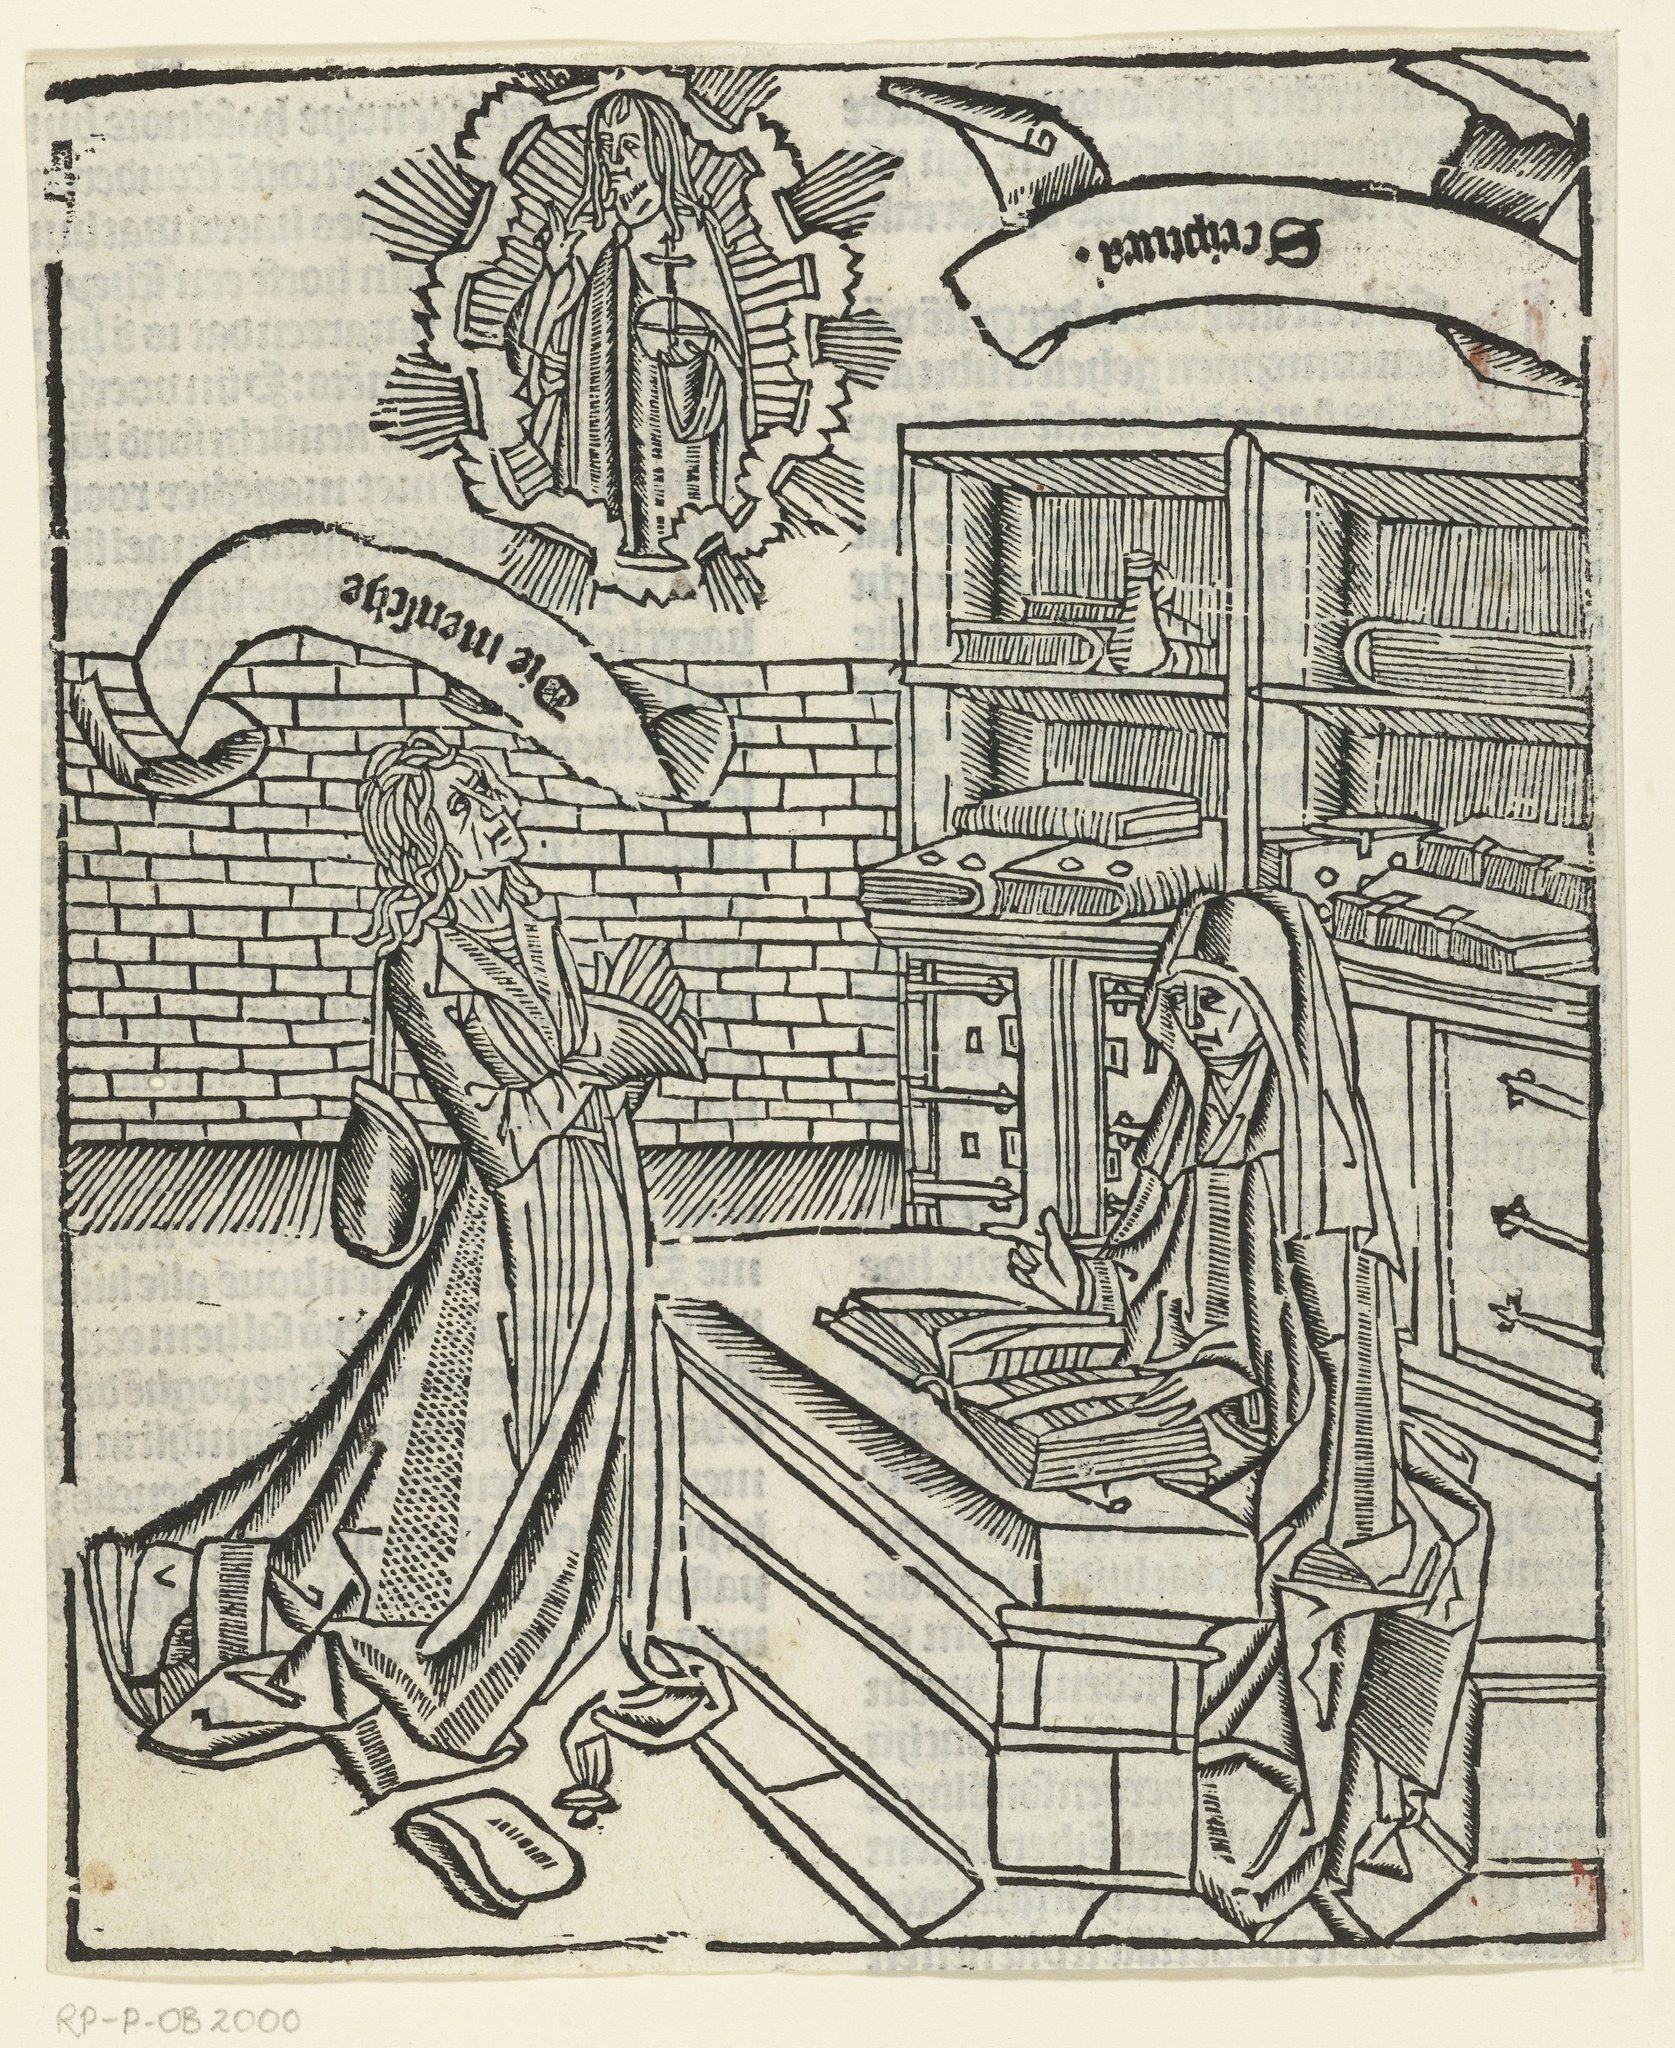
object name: print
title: Die mensche. Scriptura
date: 1480-1500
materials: paper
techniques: woodcut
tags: abstract ideas and concepts (+ abstract concept represented by female figure), reading the bible or other religious books, the bible as a book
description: Eén blad van 113 uit Ludolphus de Saxonia, "Dit es dleué ons liefs heeren ihesu christi". Anonieme Nederlandse vertaling. Uitgegeven door Henrick Eckert van Homberch te Antwerpen in 1503. Botke, K. Deze 113 houtsneden, die meestal reeds in vroege Nederlandse boeken gebruikt zijn, worden toegeschreven aan de tweede Meester van Delft, de Meester van de Delbecq-Schreiber-passie en de Meester van de Virgo inter Virgines. In Conway (1884) en in "De gulden passer"(1951) zijn tevens eerdere versies opgenomen. Botke, K.